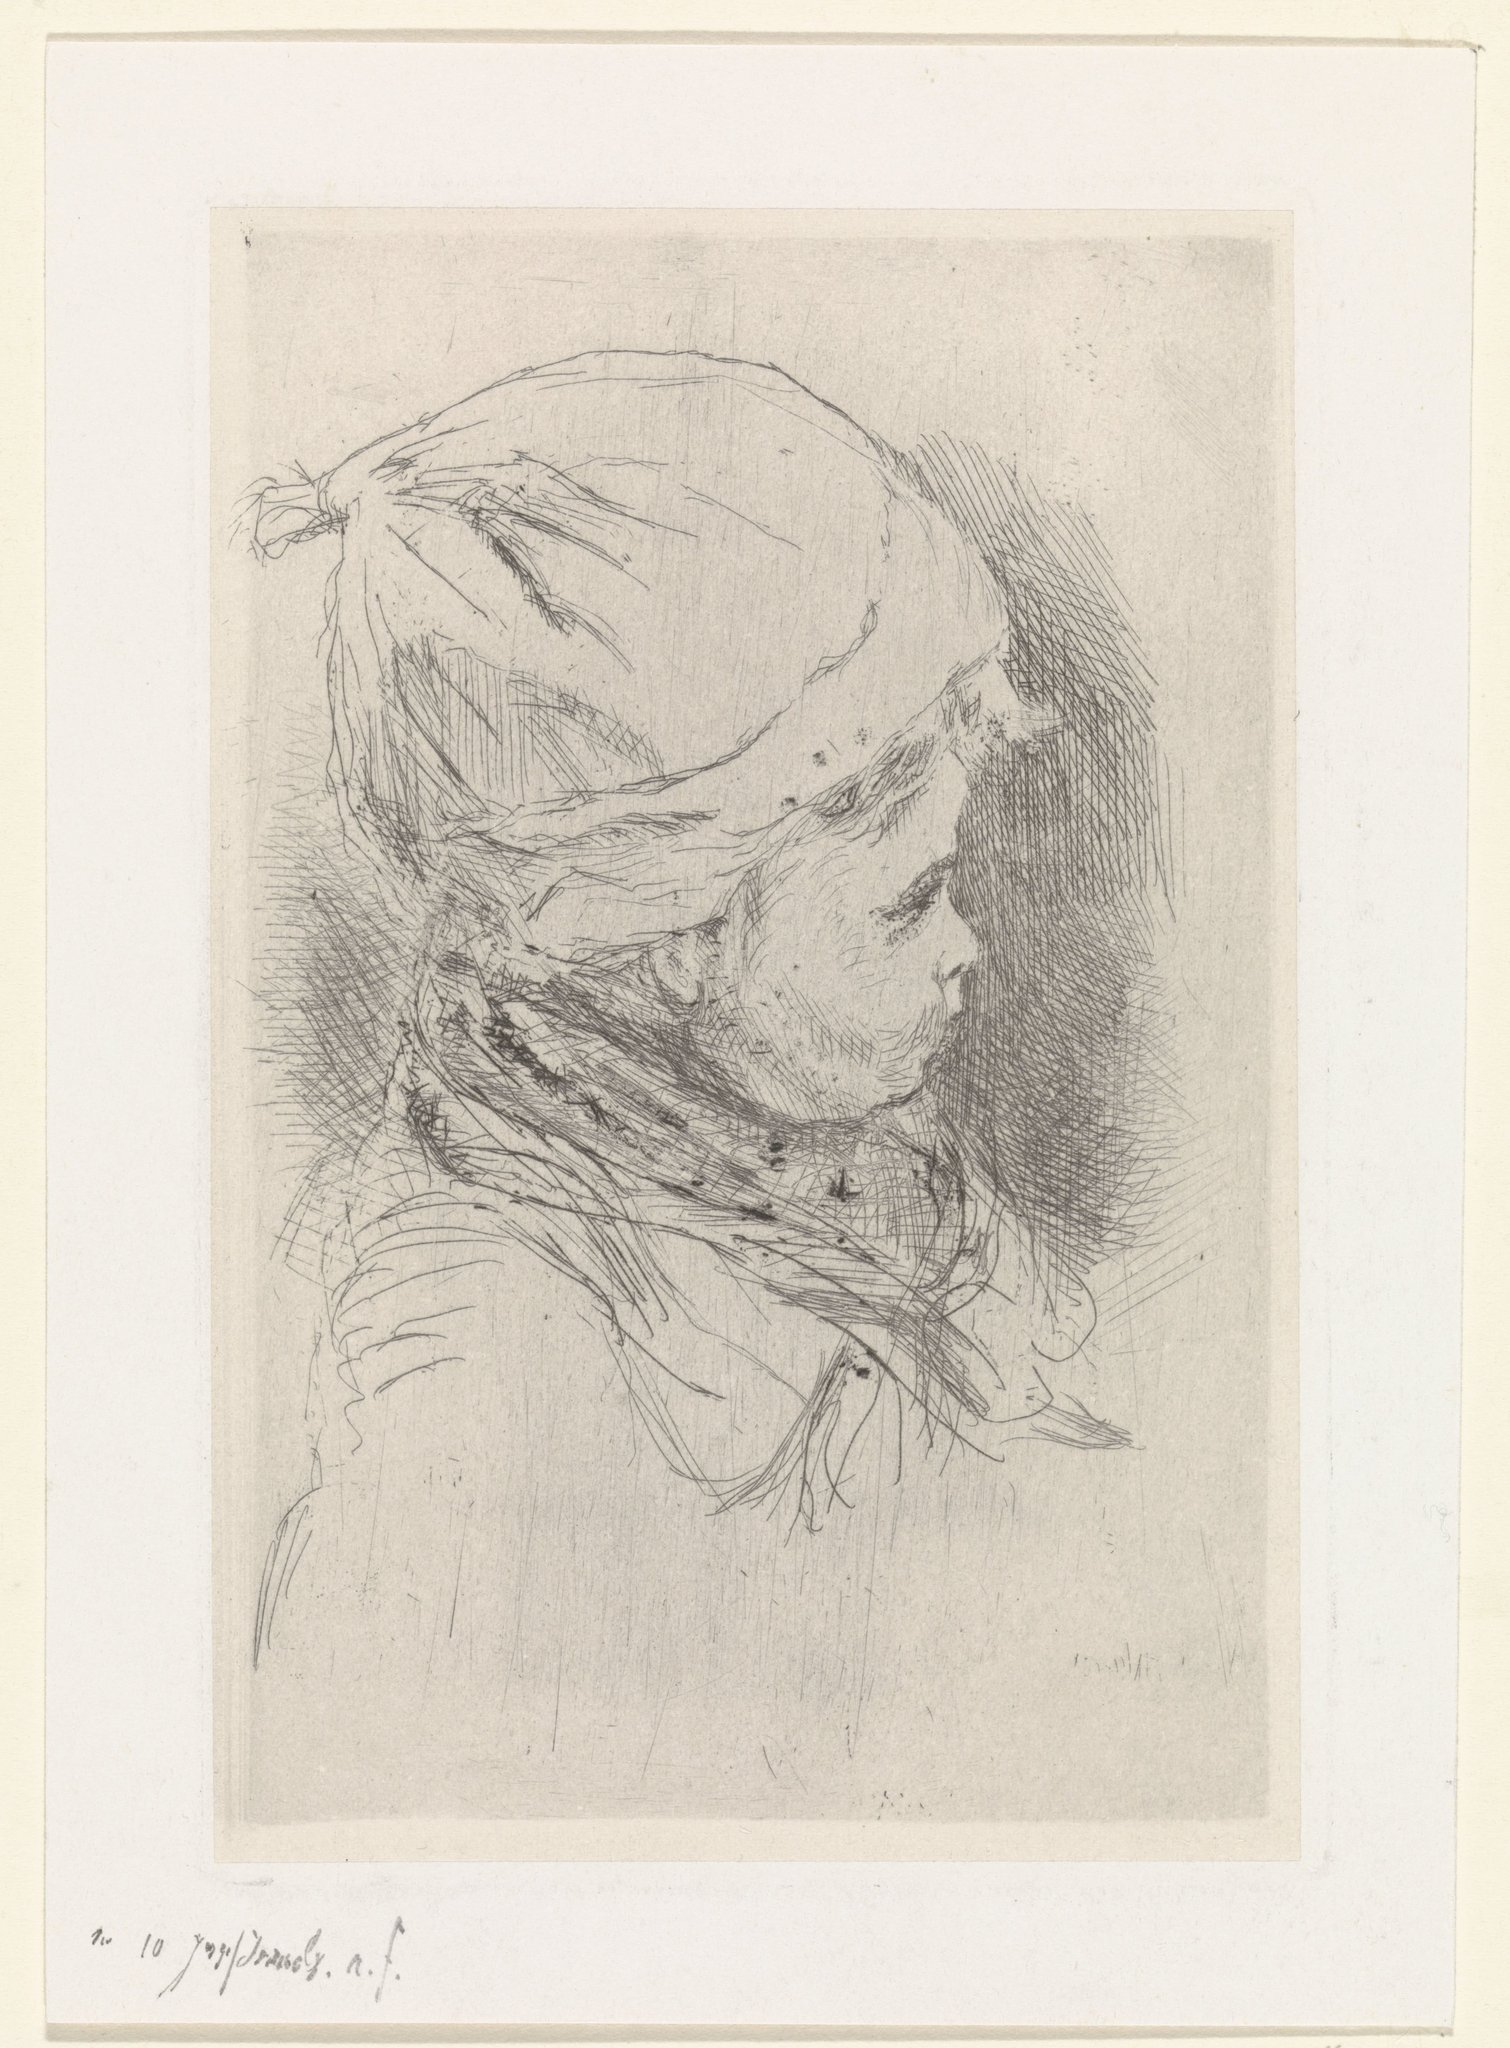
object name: print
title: Kleine Jan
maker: jozef israëls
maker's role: draughtsman, painter, print maker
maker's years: 1824-1911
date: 1834-1878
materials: paper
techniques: etching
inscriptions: collector's mark: Lugt 2228, signature: ‘no. 10 Jozef Israels a.f.’